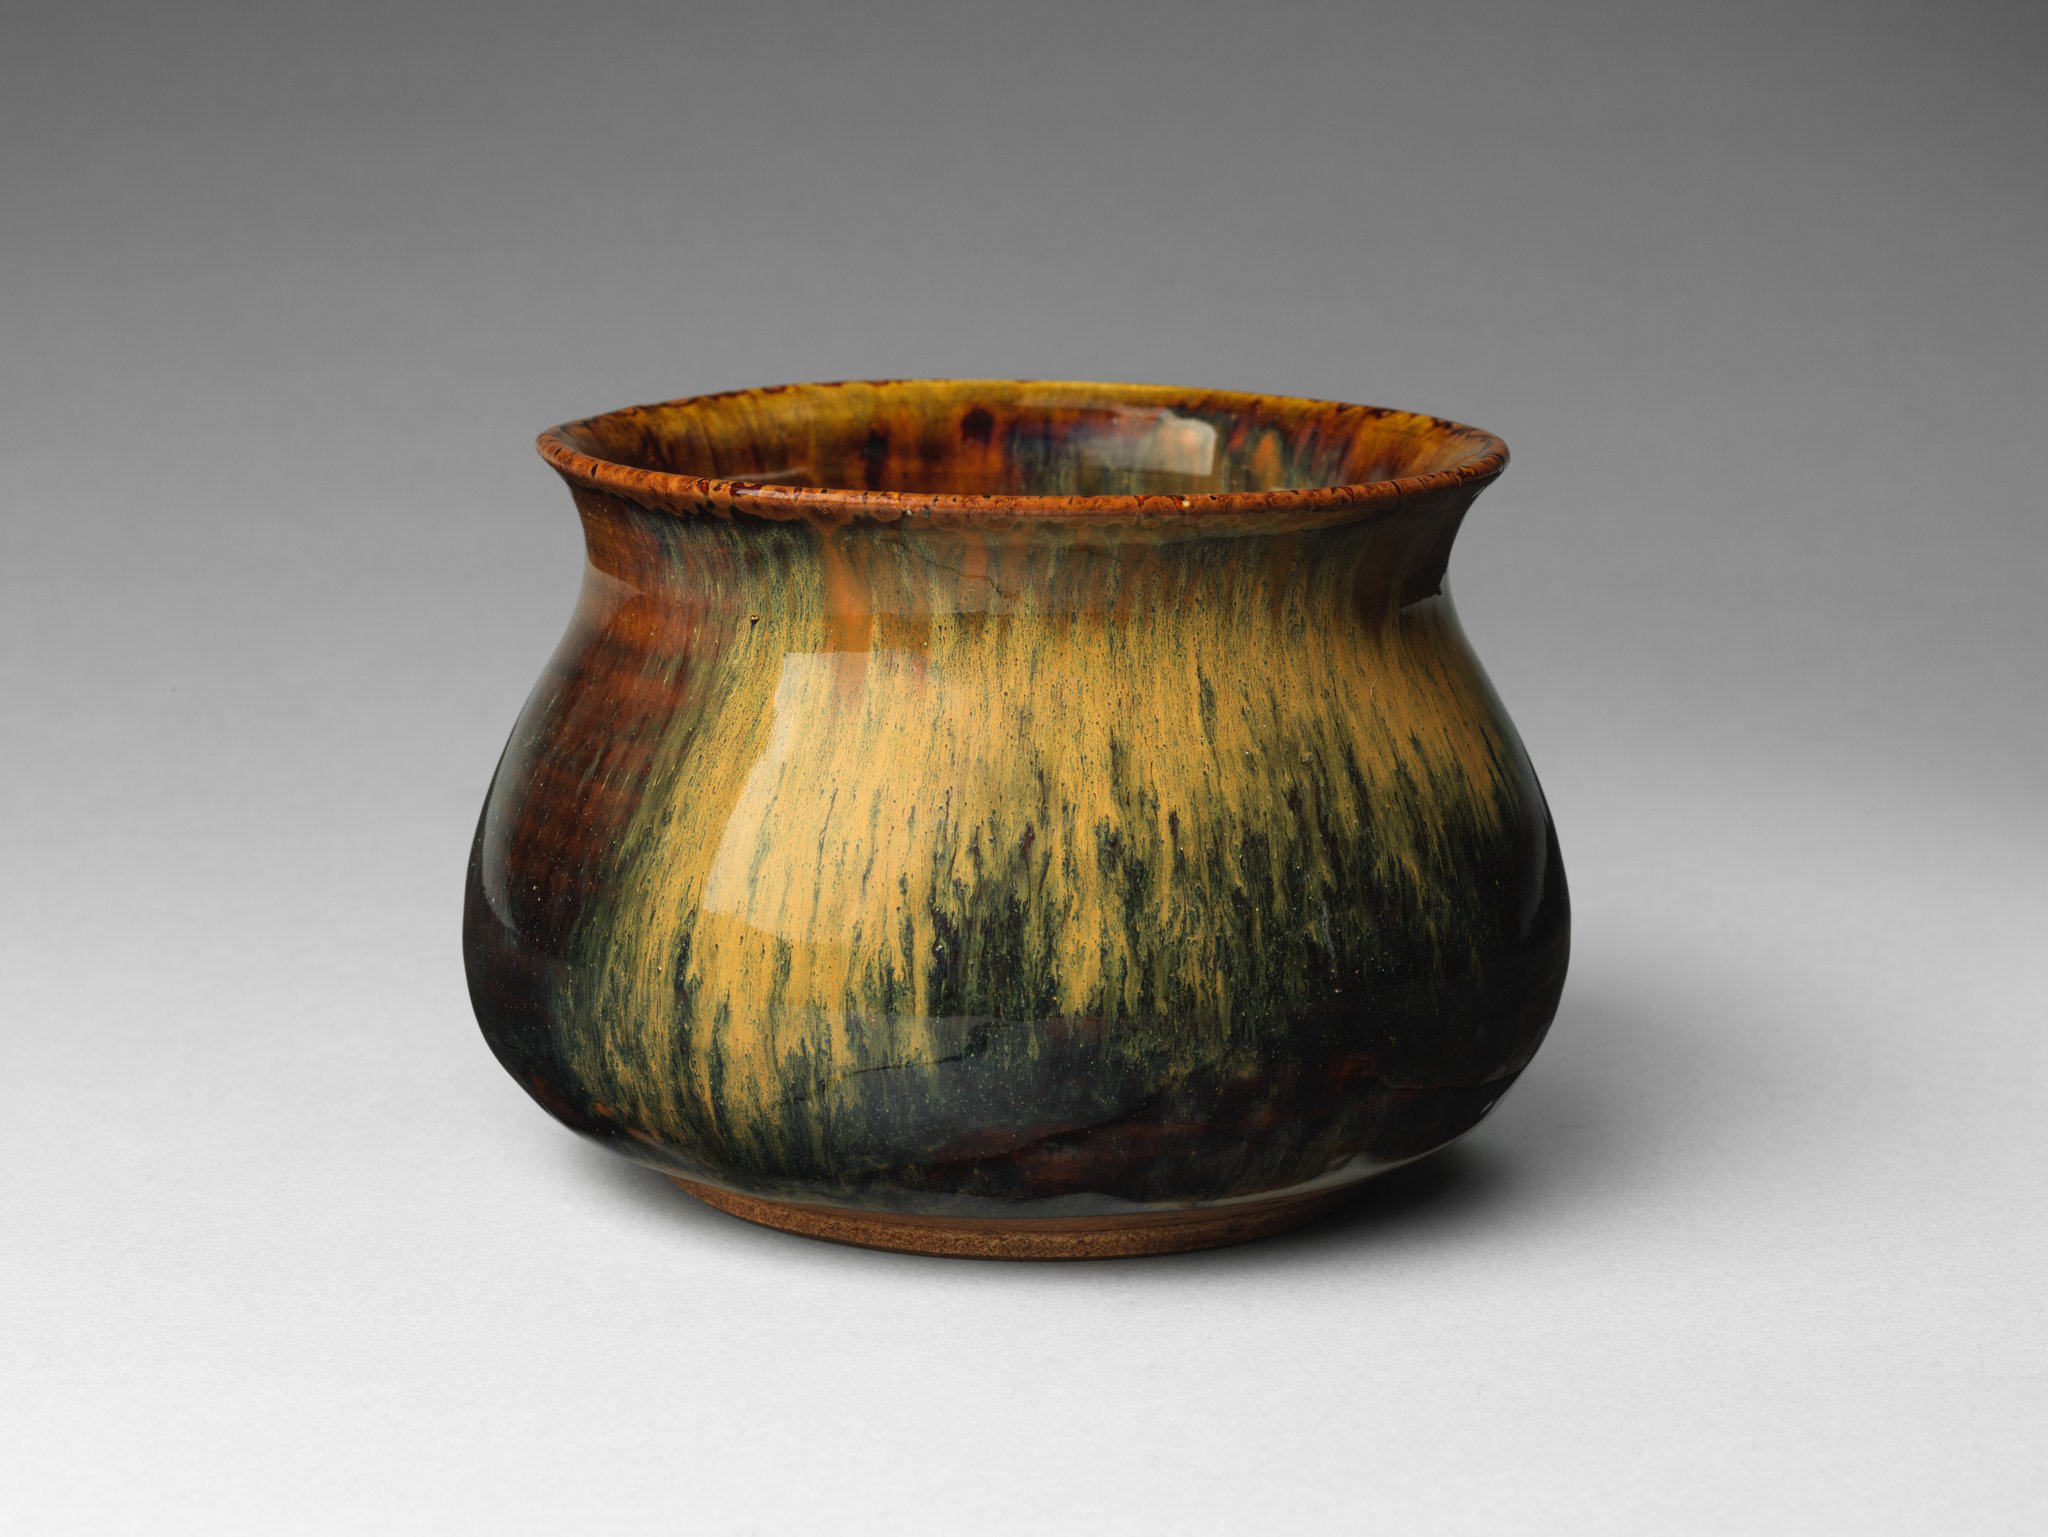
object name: used water container kensui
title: Used-Water Container (Kensui)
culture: japanese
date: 1834-1866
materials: glaze, iron, stoneware